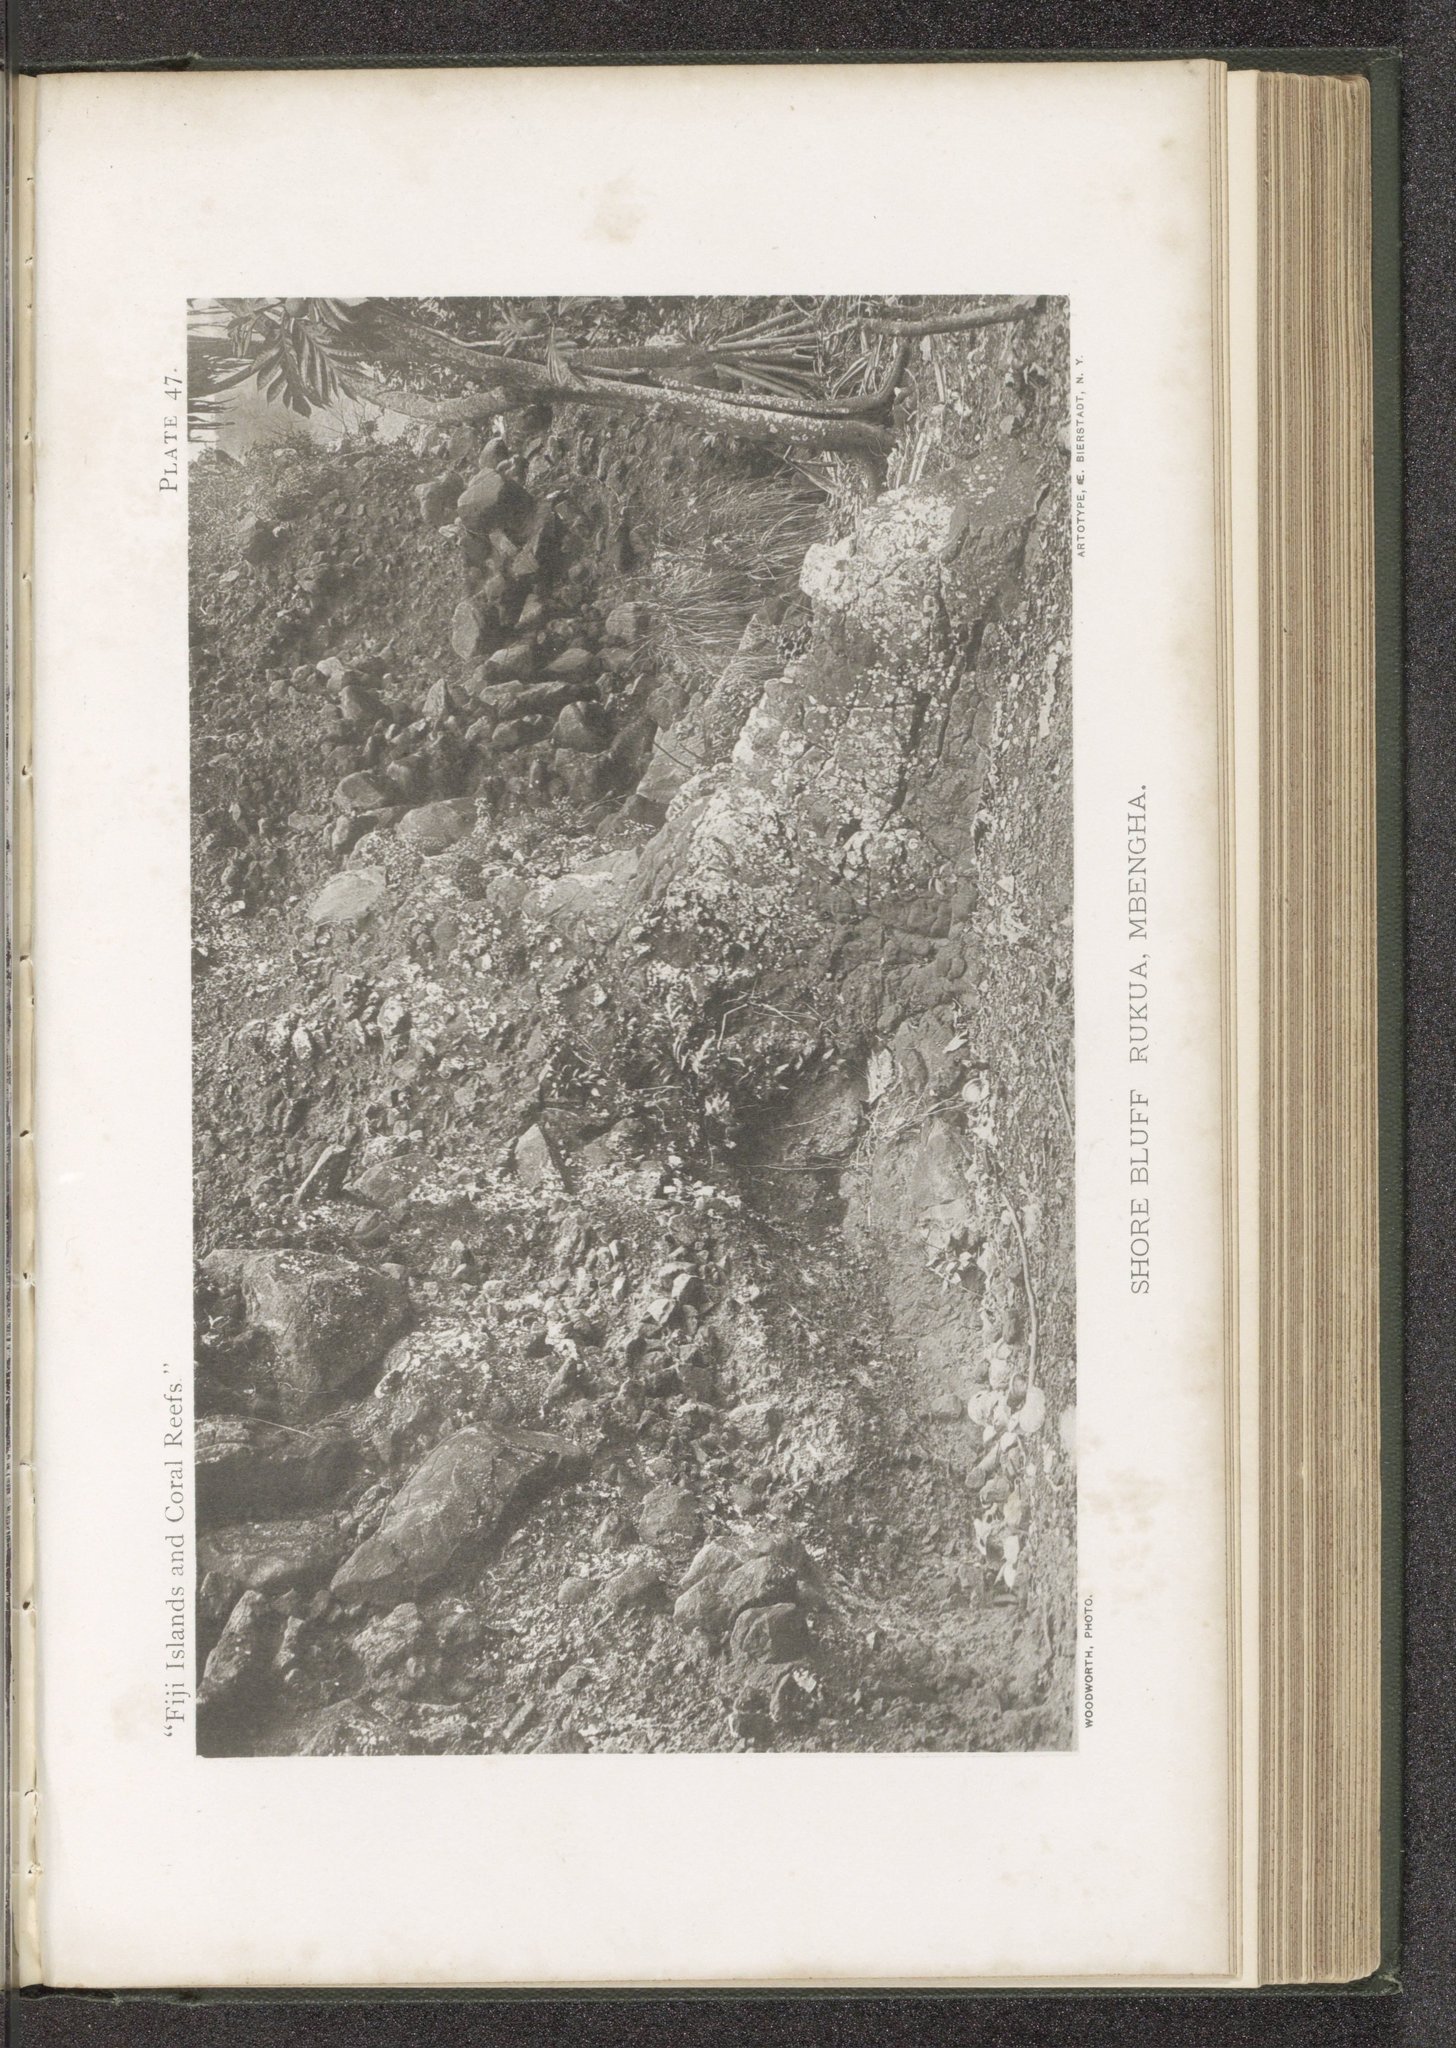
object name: photomechanical print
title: Gezicht op een kaap bij Rukua op Beqa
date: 1885-1899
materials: paper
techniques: photograph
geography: new york city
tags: coastal cliff or crag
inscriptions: number: ‘Plate 47.’, name: ‘Artotype, E. Bierstadt N. Y.’, name: ‘Woodworth, Photo.’